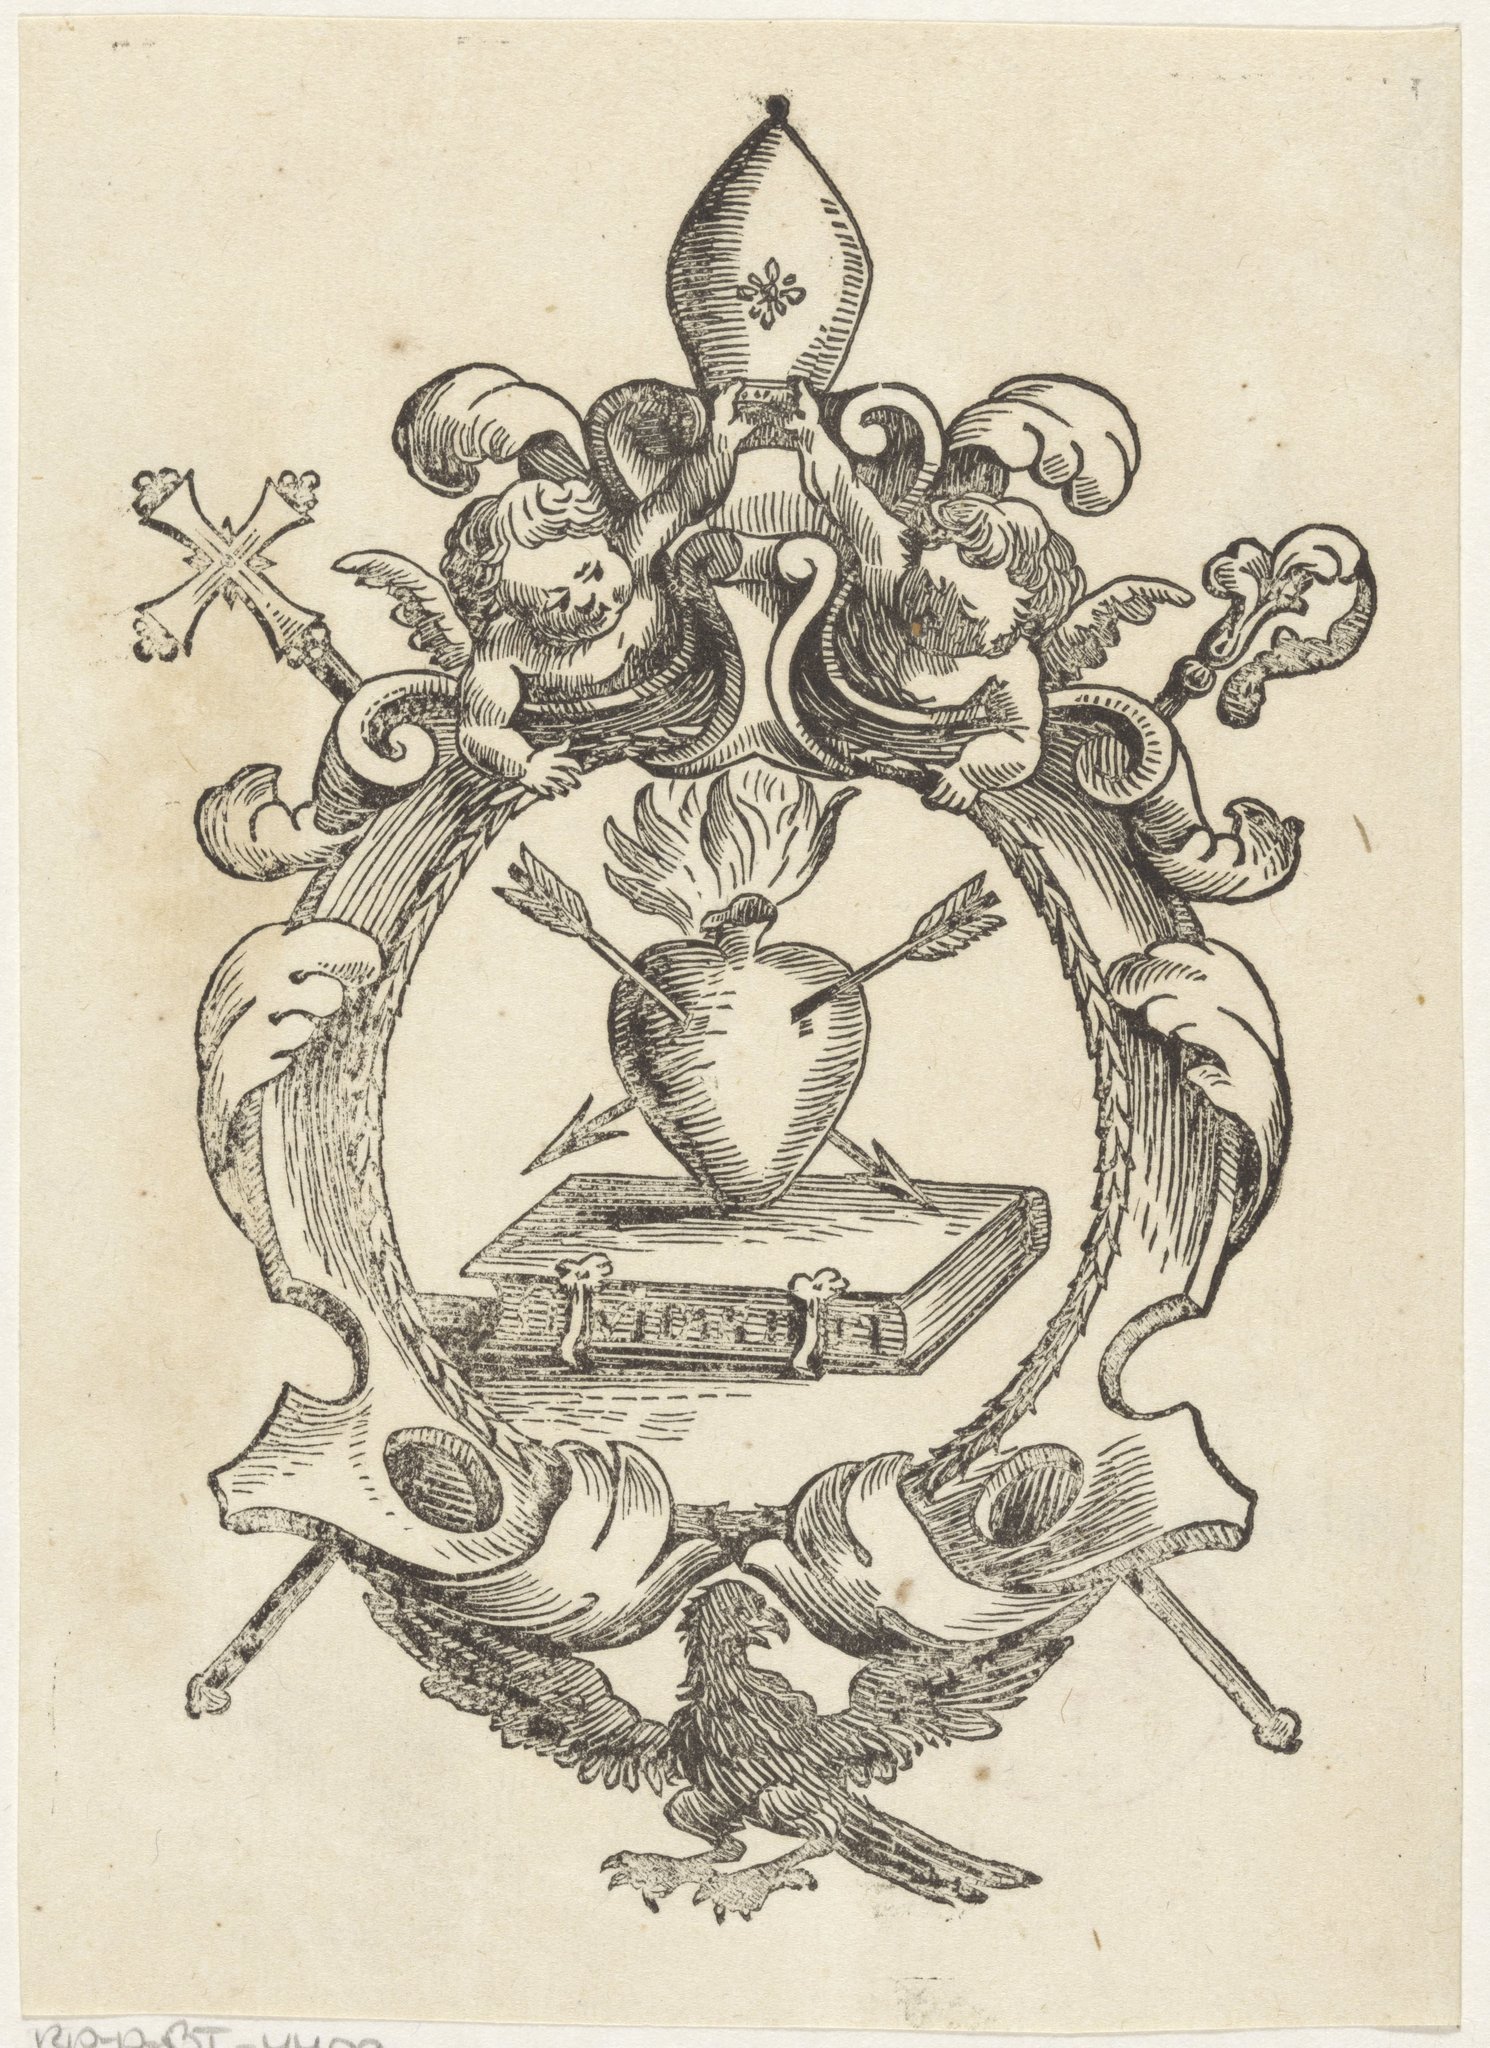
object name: print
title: Brandend hart met pijlen in een geornamenteerd ovaal met putti en een vogel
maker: Anonymous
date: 1600-1699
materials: paper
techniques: woodcut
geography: netherlands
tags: heart symbolism, birds, cupids: 'amores', 'amoretti', 'putti'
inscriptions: collector's mark: Lugt 240